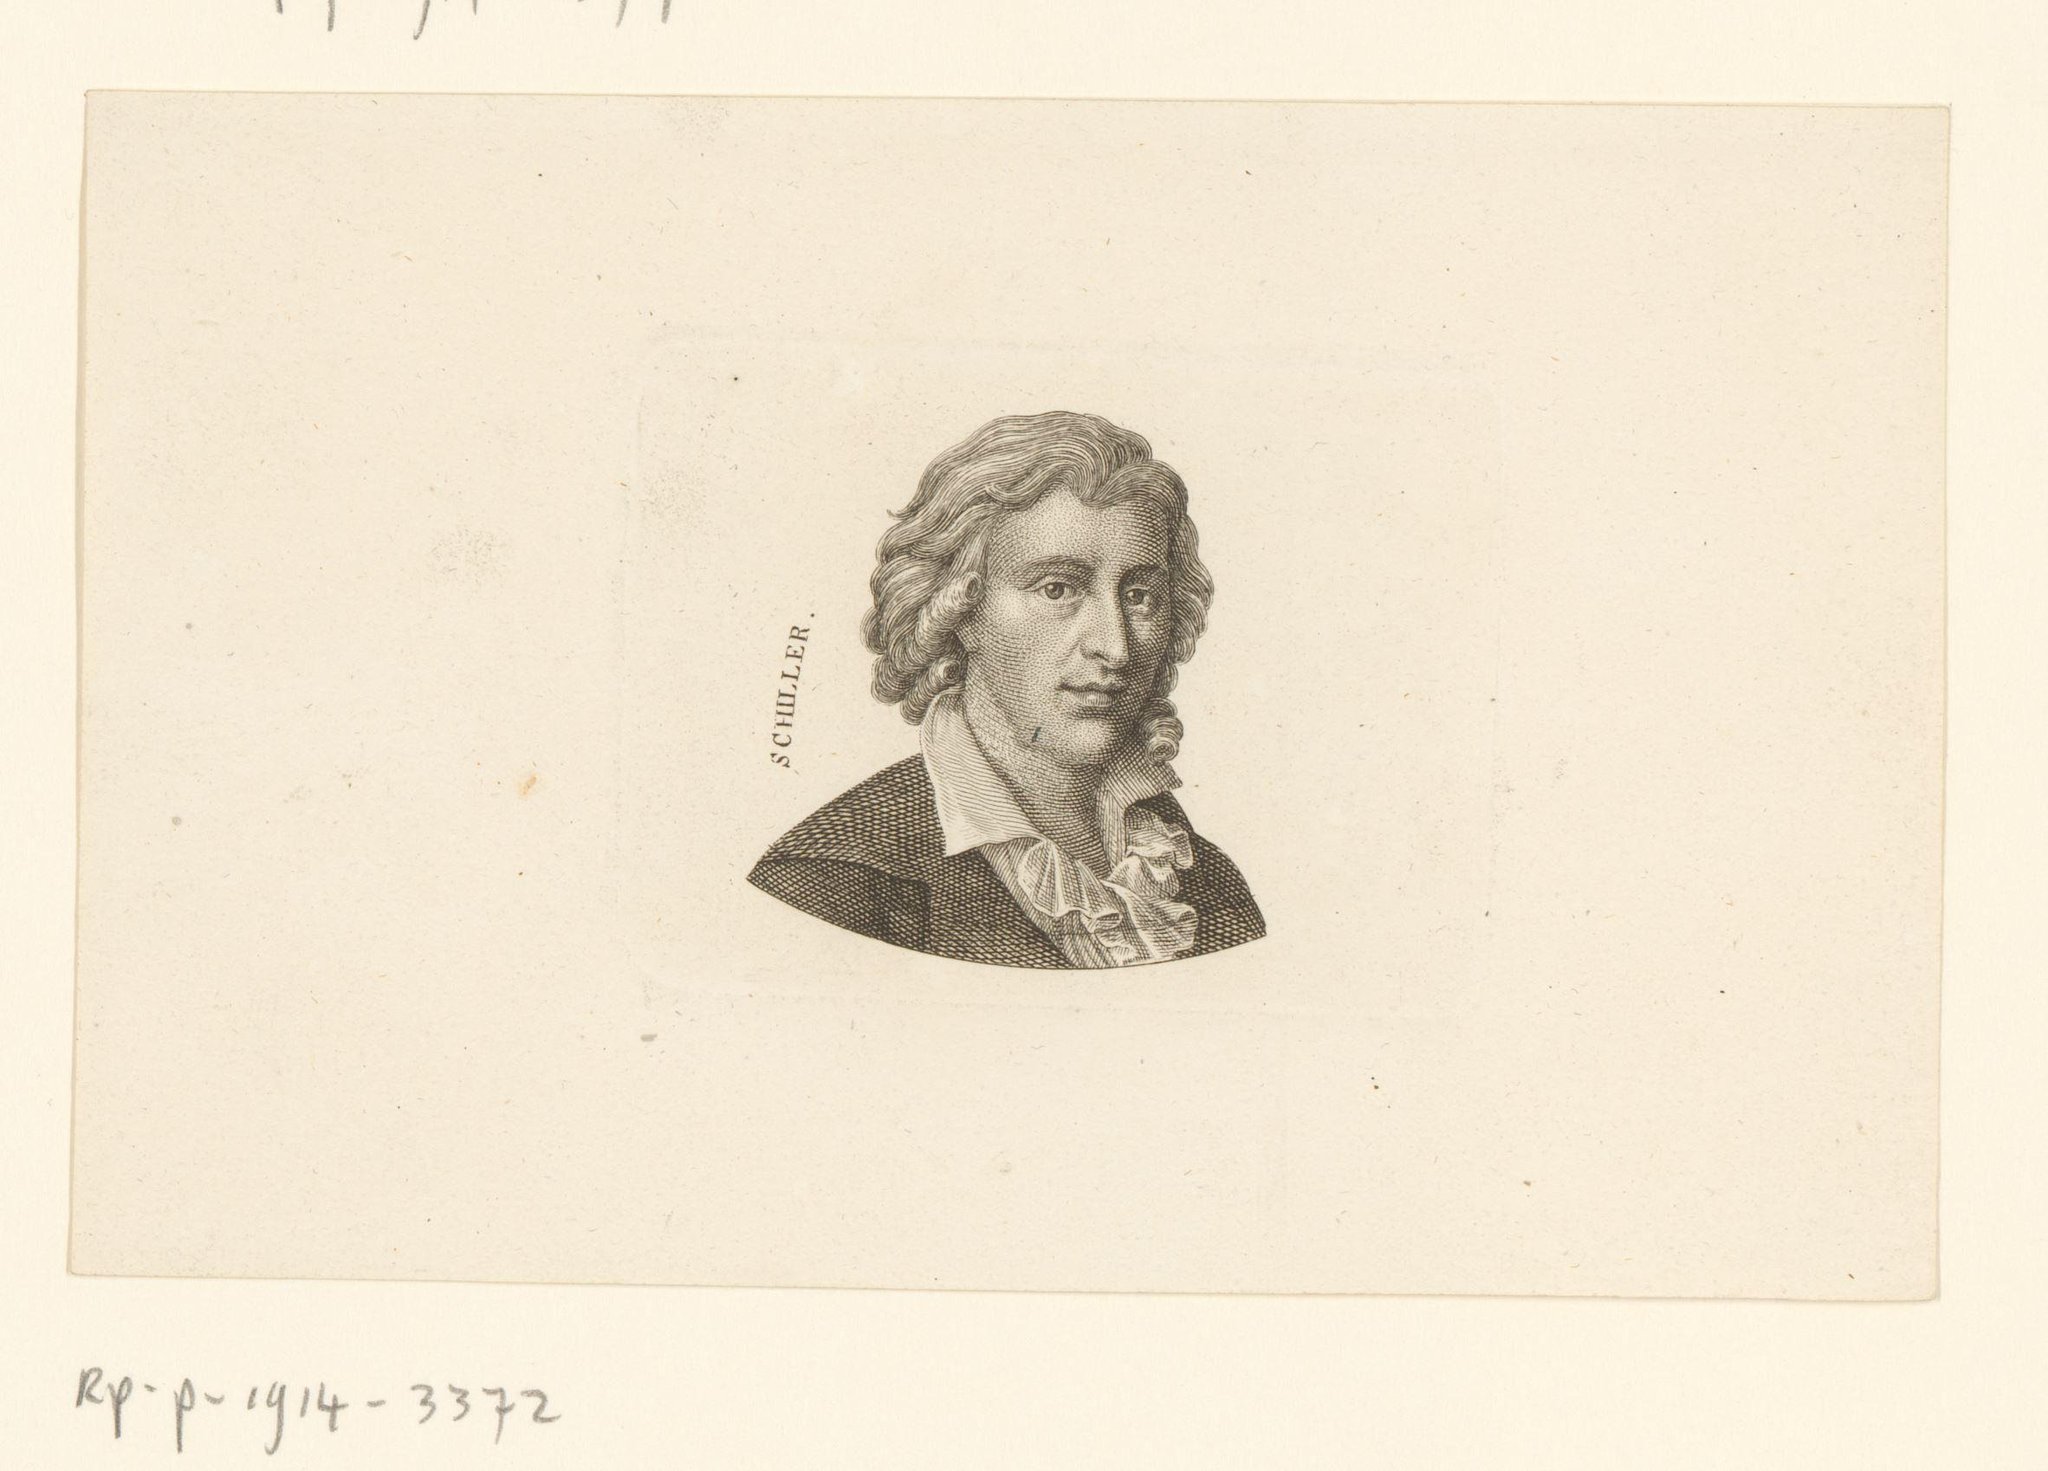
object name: print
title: Portret van Friedrich von Schiller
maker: ernst ludwig riepenhausen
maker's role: print maker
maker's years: 1765-1840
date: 1775-1840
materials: paper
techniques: engraving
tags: friedrich von schiller, historical persons, writer, poet, author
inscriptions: collector's mark: Lugt 2228